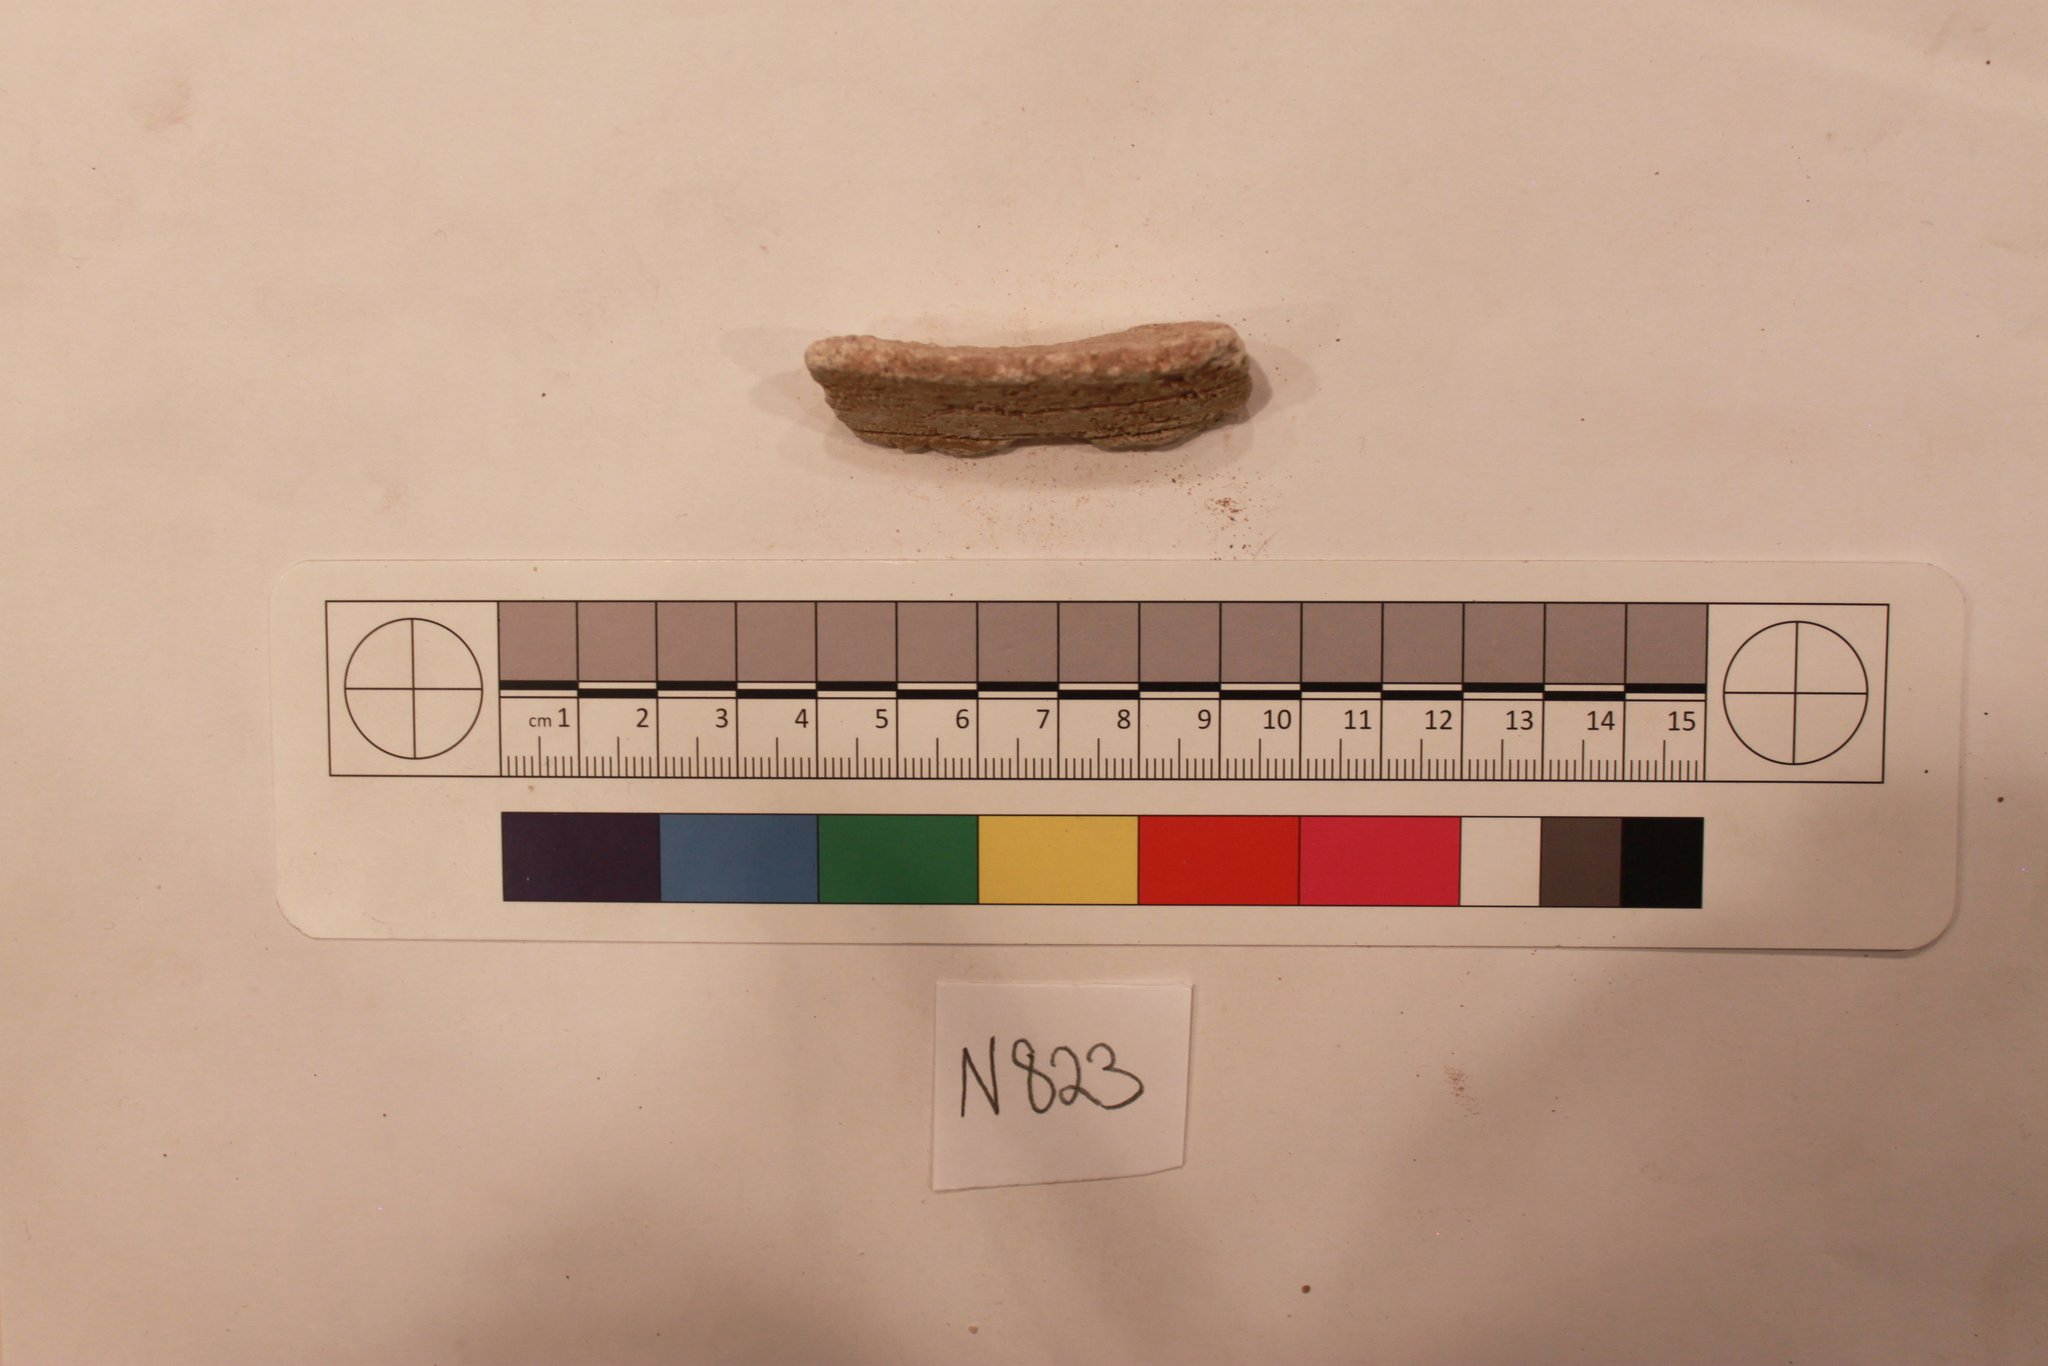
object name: fragment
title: Stucco Fragment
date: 701-1200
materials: plaster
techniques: carving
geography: iran